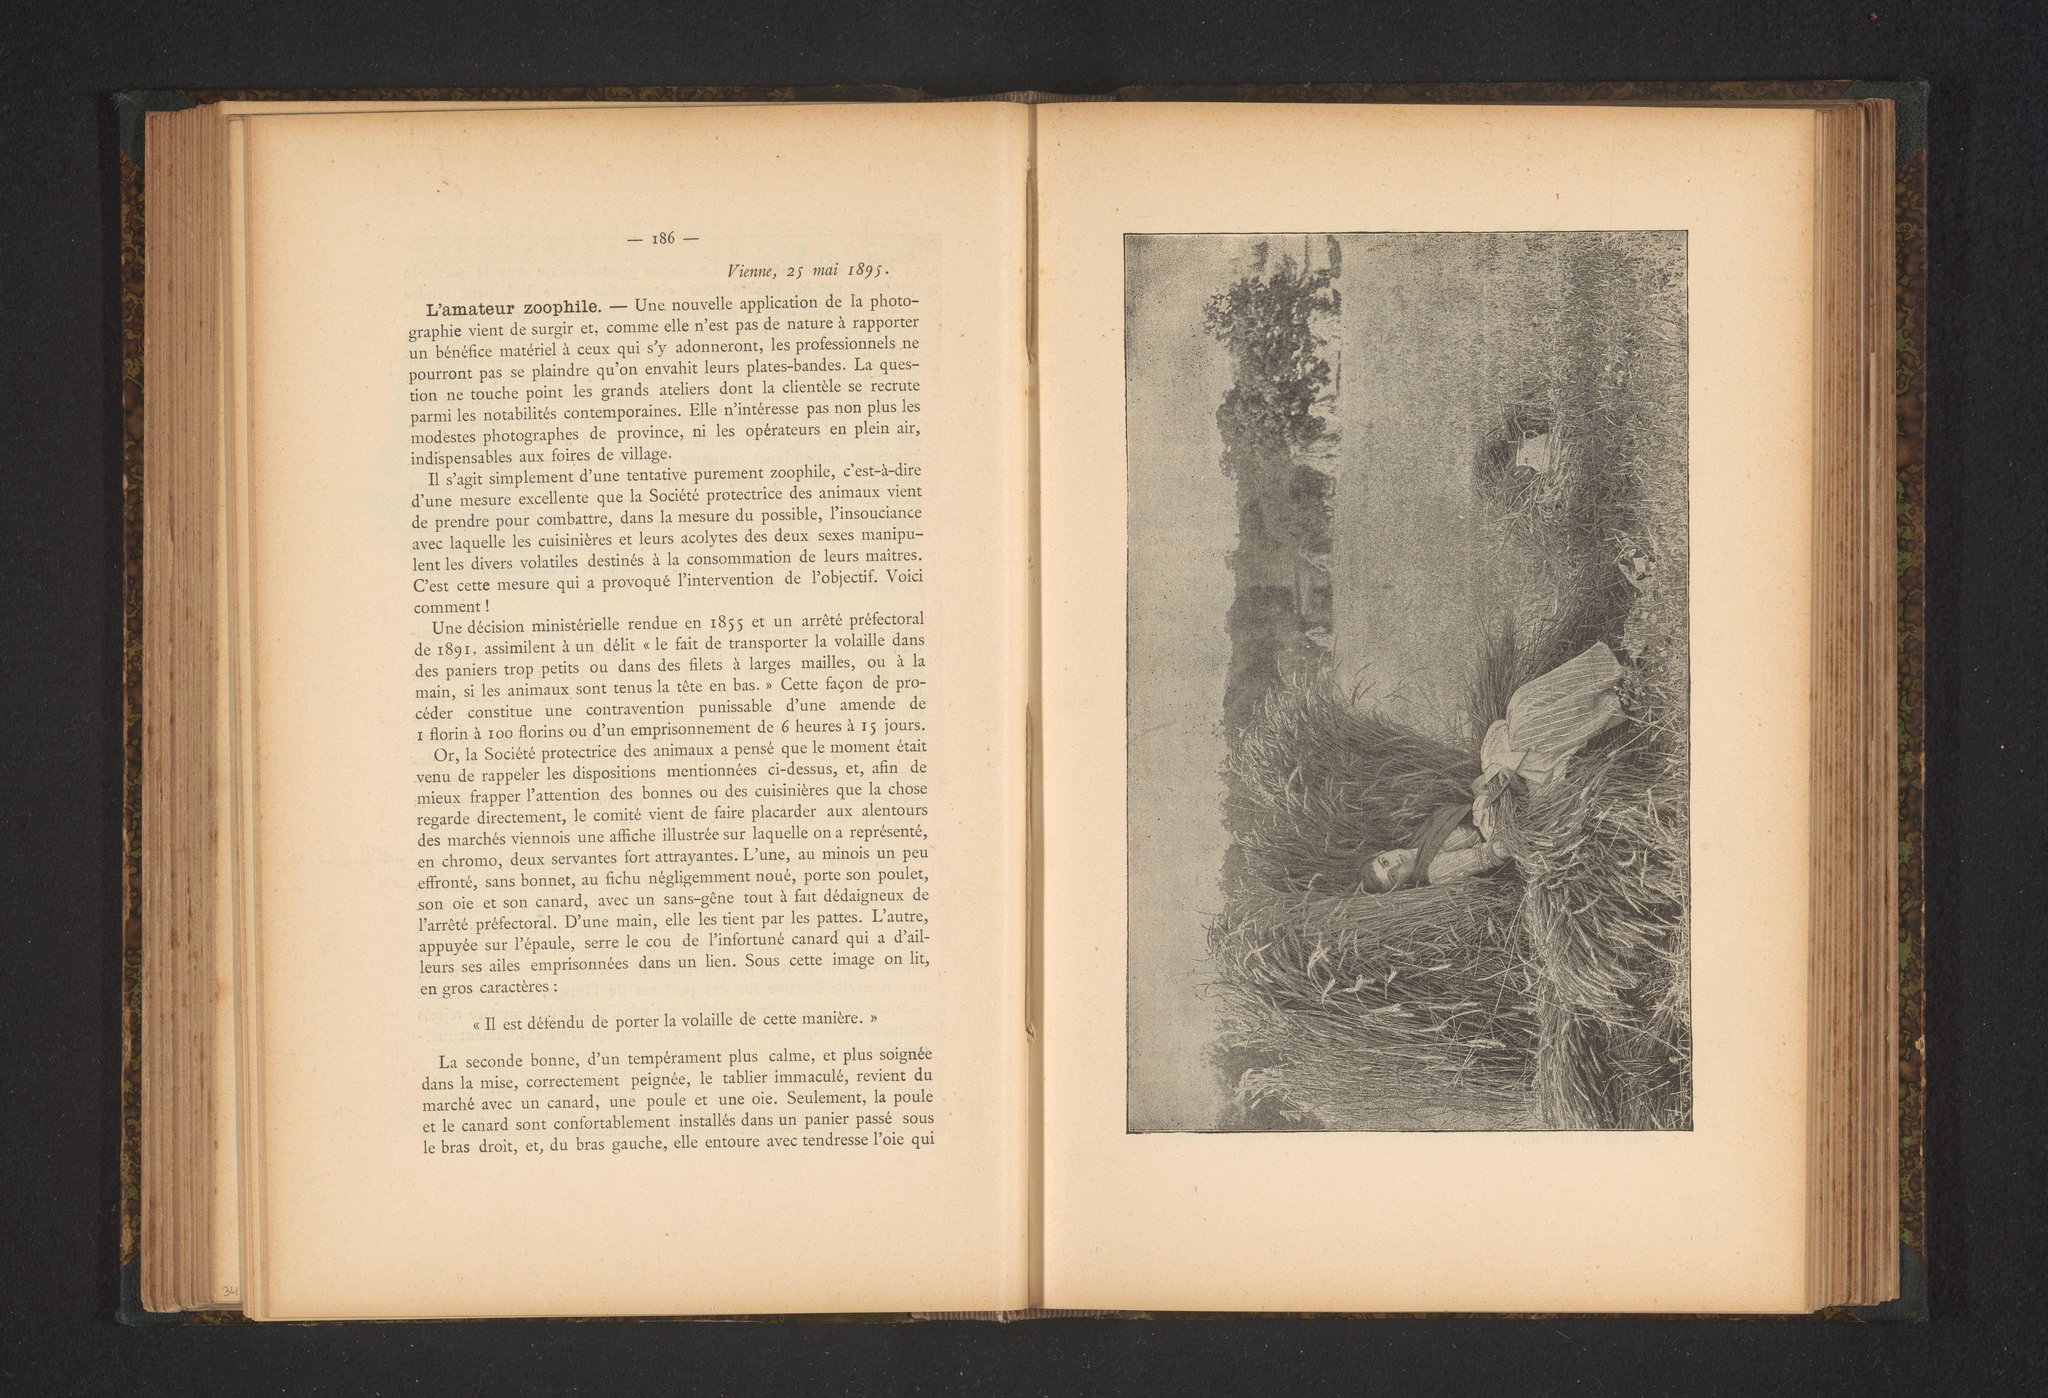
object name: reproduction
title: Reproductie van een ontwerp van een persoon die in een rietkraag zit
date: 1890-1895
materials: paper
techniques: autotype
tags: sitting figure, meadow, pasture, plants and herbs: reed